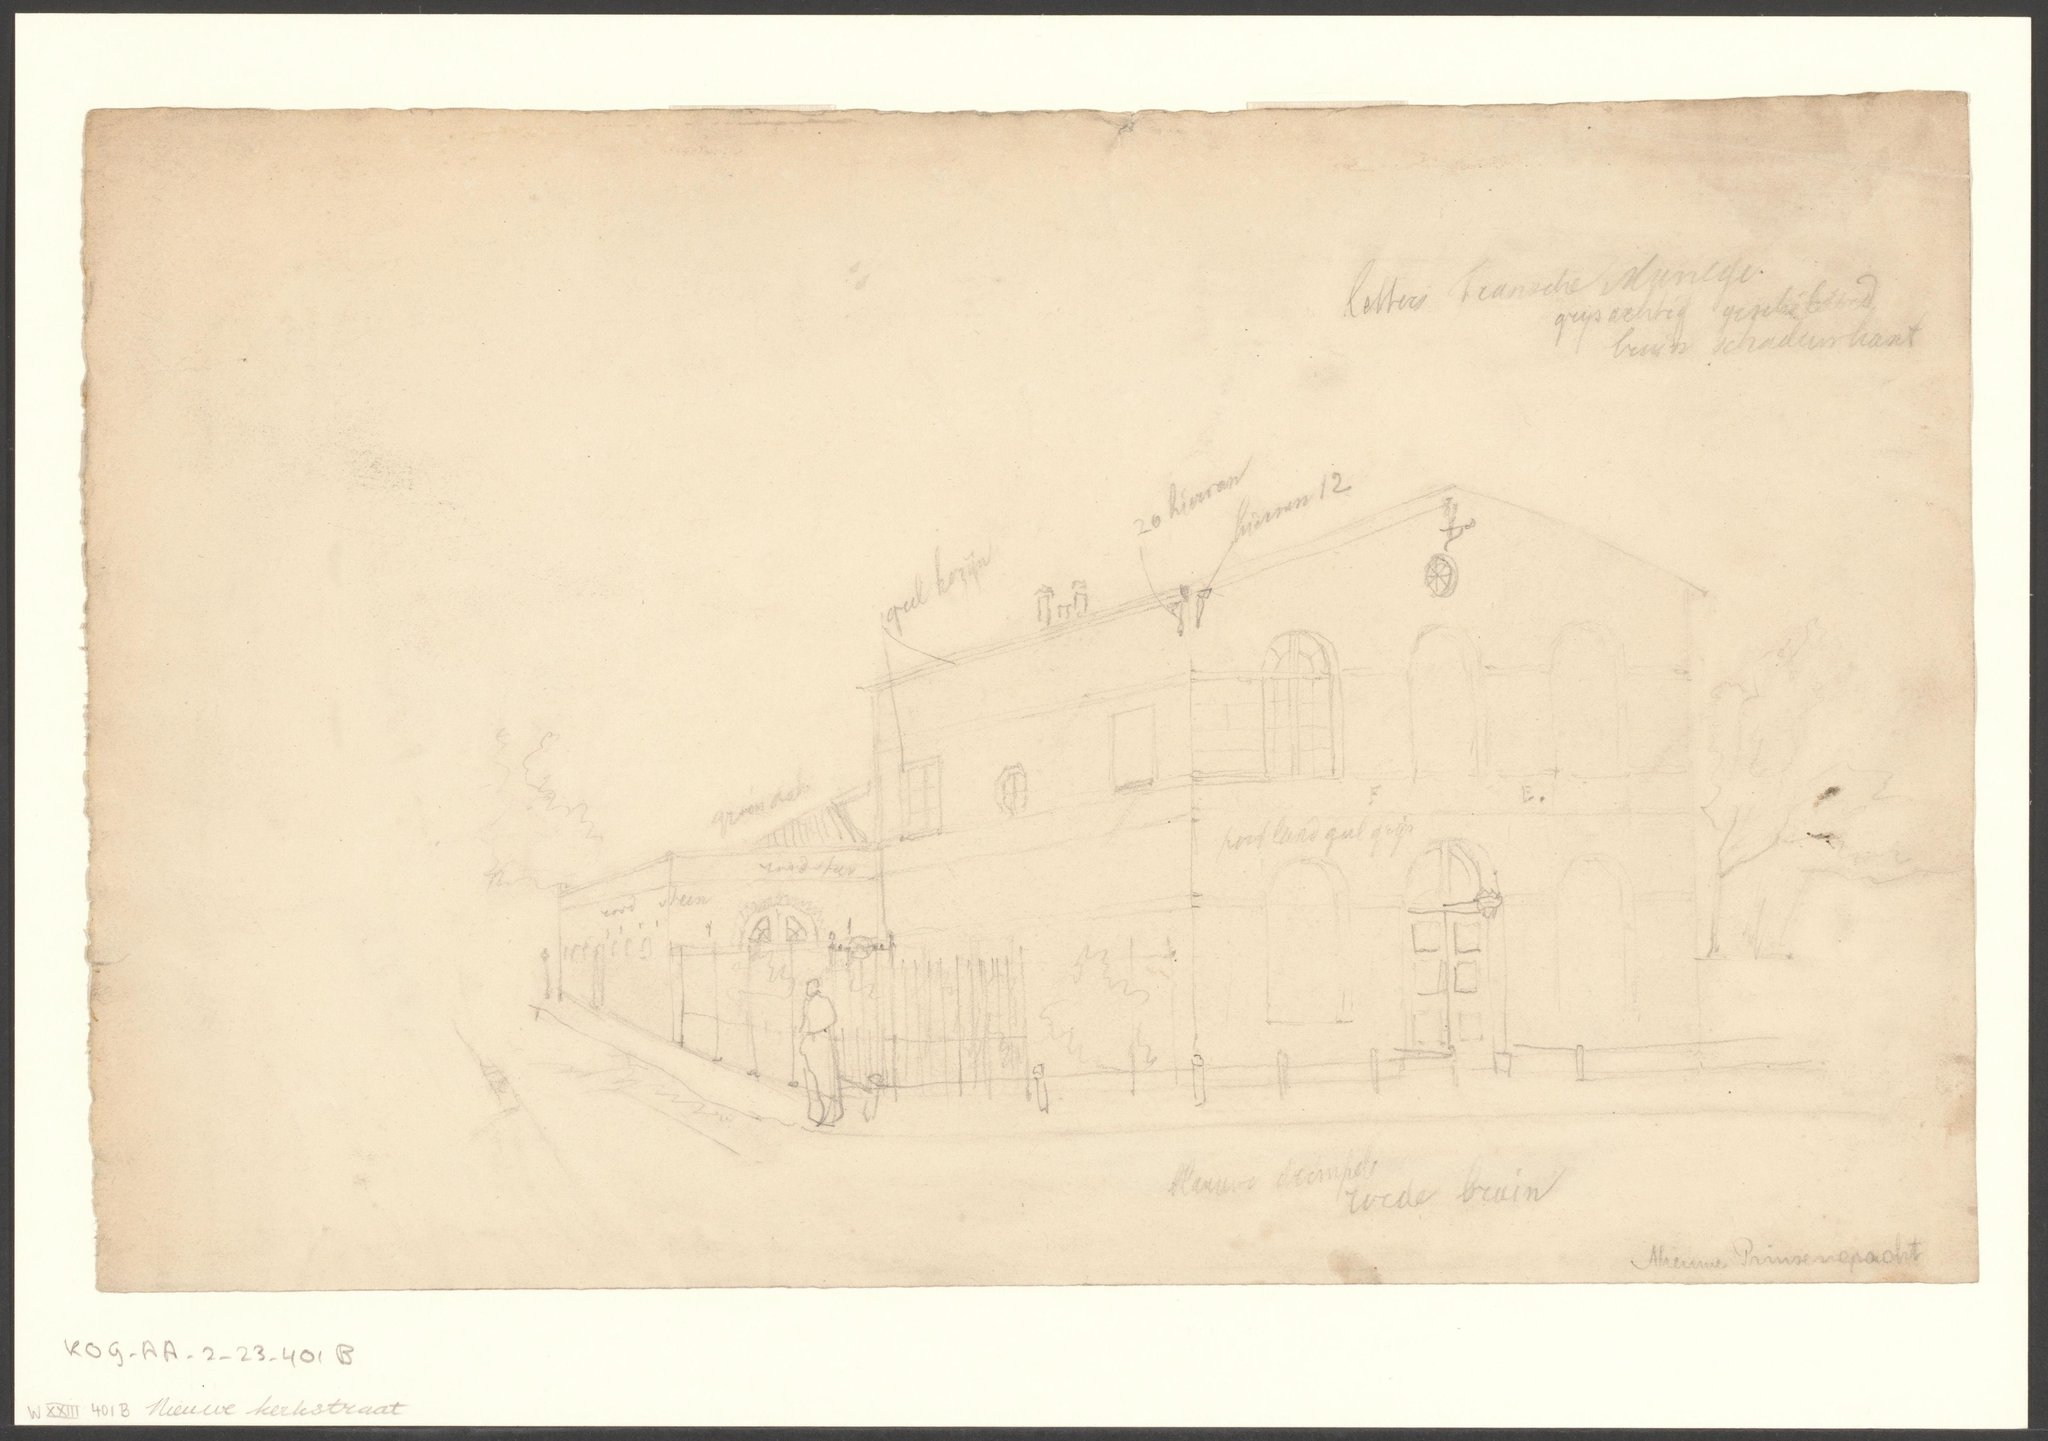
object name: drawing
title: Gezicht op de Nieuwe Kerkstraat gezien naar de Franse Manege, hoek Manegestraat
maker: johan george lodewijk rieke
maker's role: draughtsman, print maker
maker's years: 1817-1898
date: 1827-1888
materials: paper, pencil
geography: amsterdam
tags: city-view in general; 'veduta', street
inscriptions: inscription: ‘letters Fransche Manege (...) bruin / Nieuwe Prinsengracht’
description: Tekening binnen de Atlas Van Eck ingedeeld op wijknummer 23.